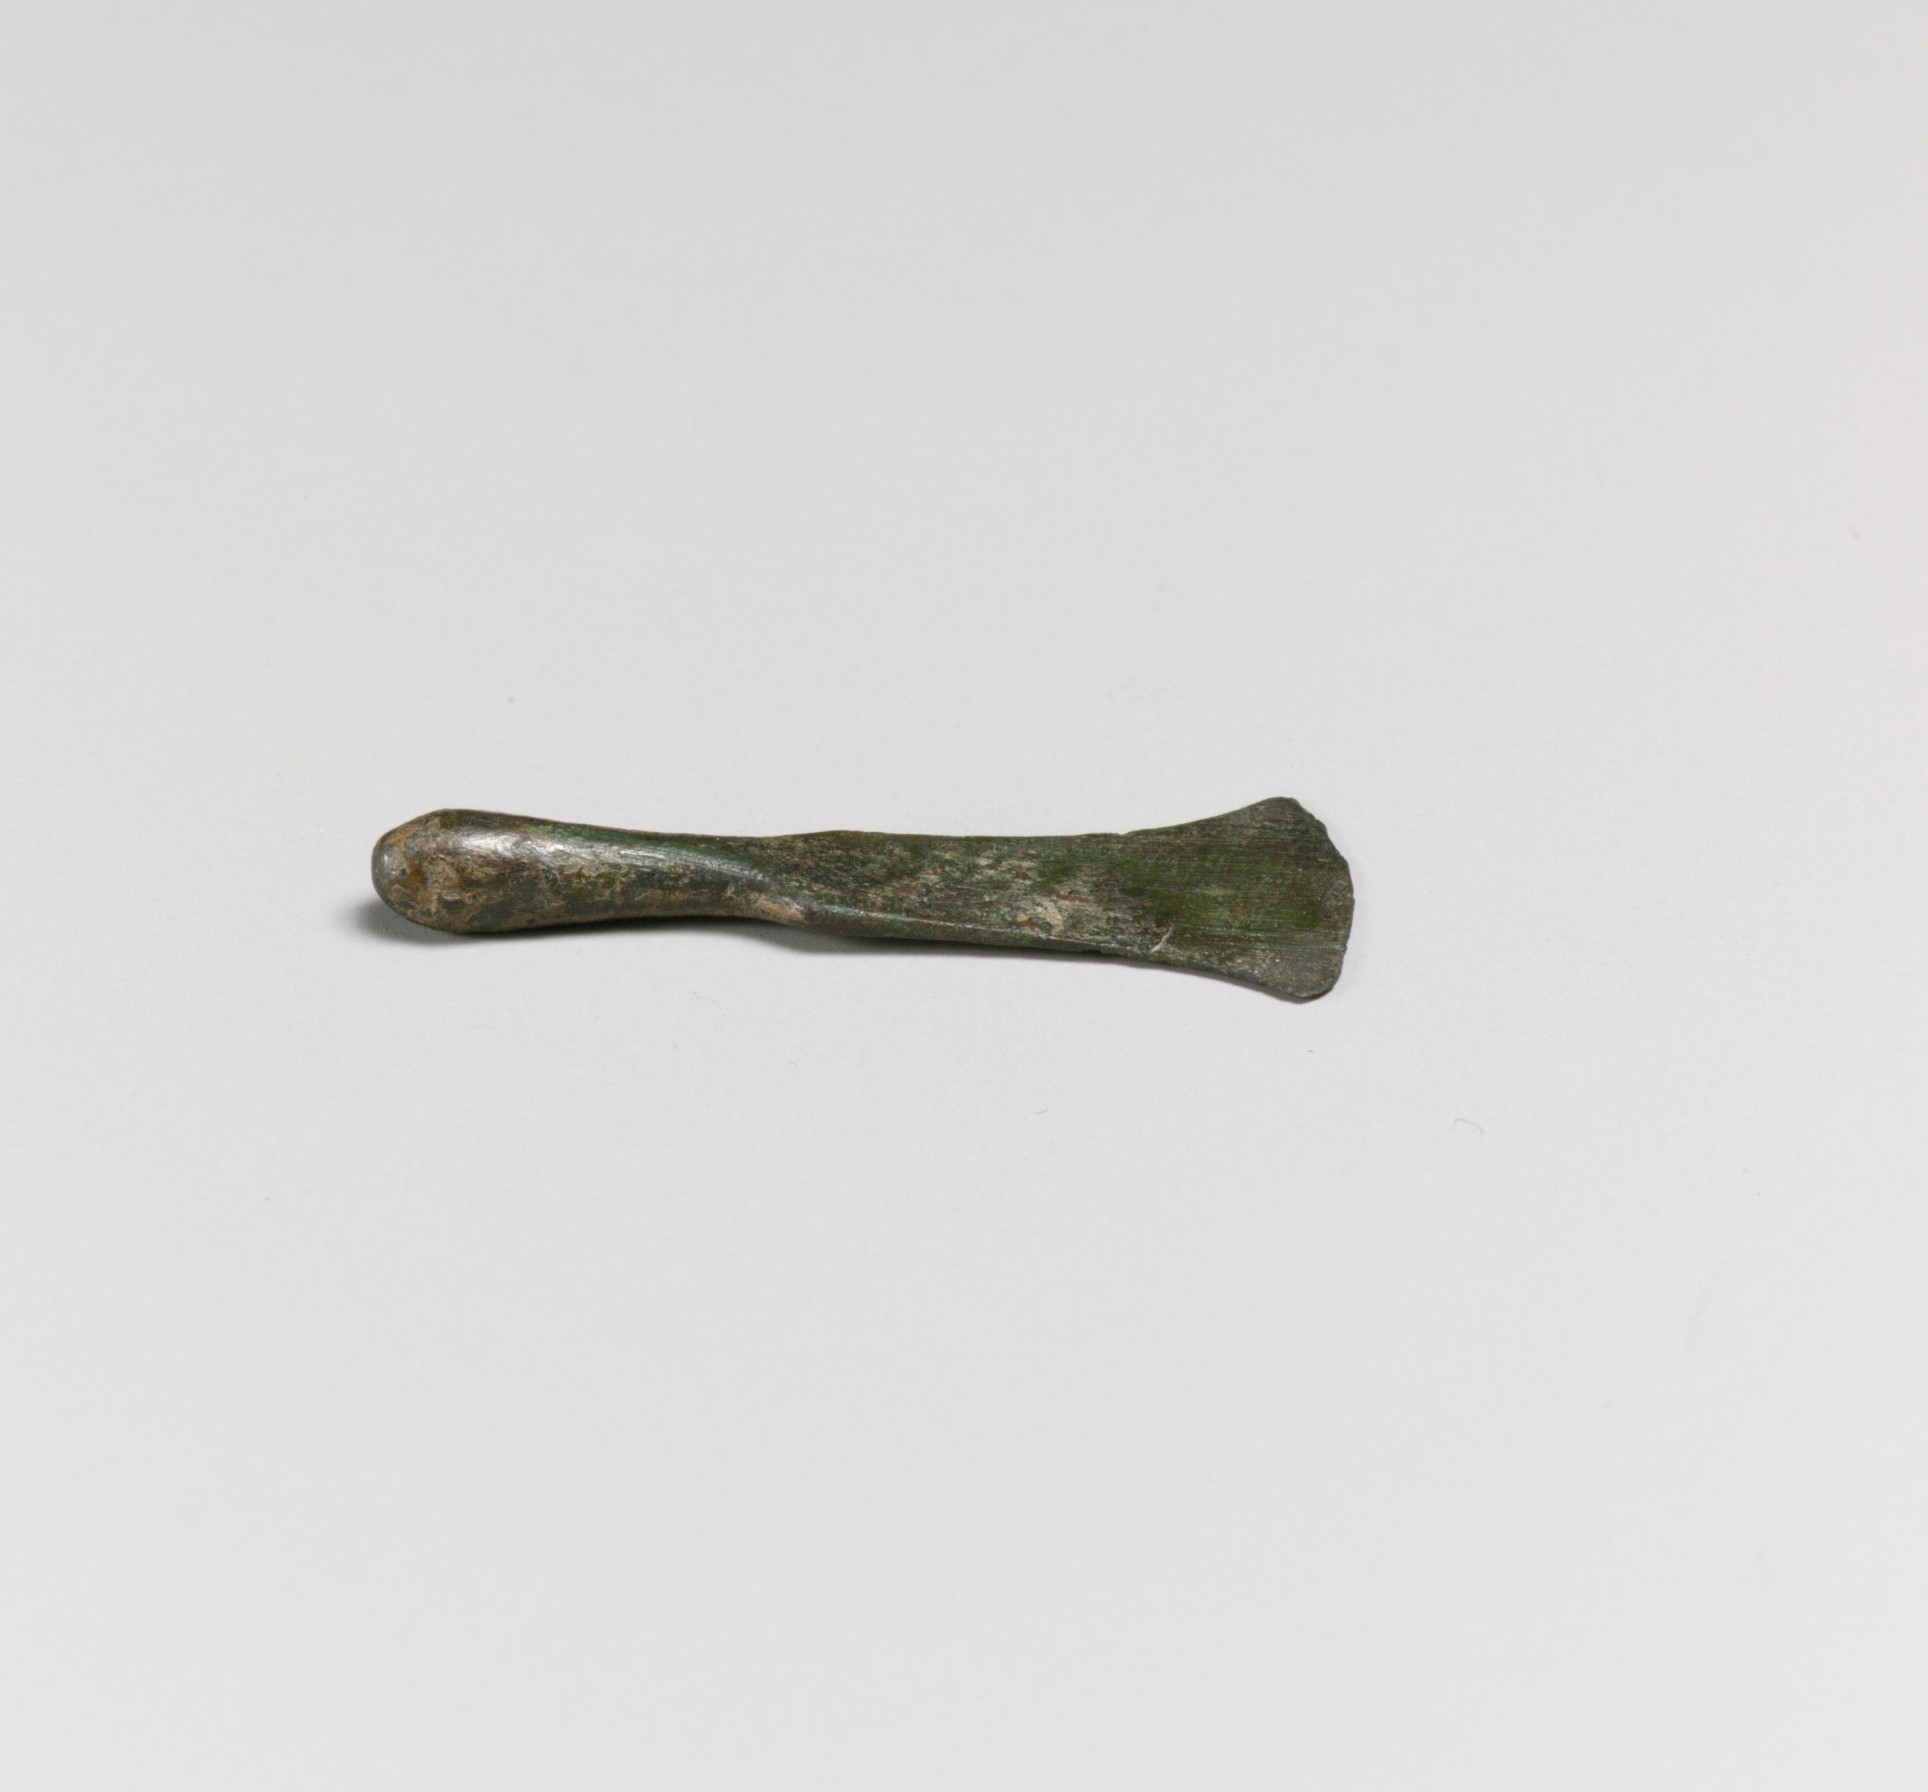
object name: trowel or cutter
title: Bronze trowel or cutter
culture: minoan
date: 2000-1001 BCE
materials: bronze